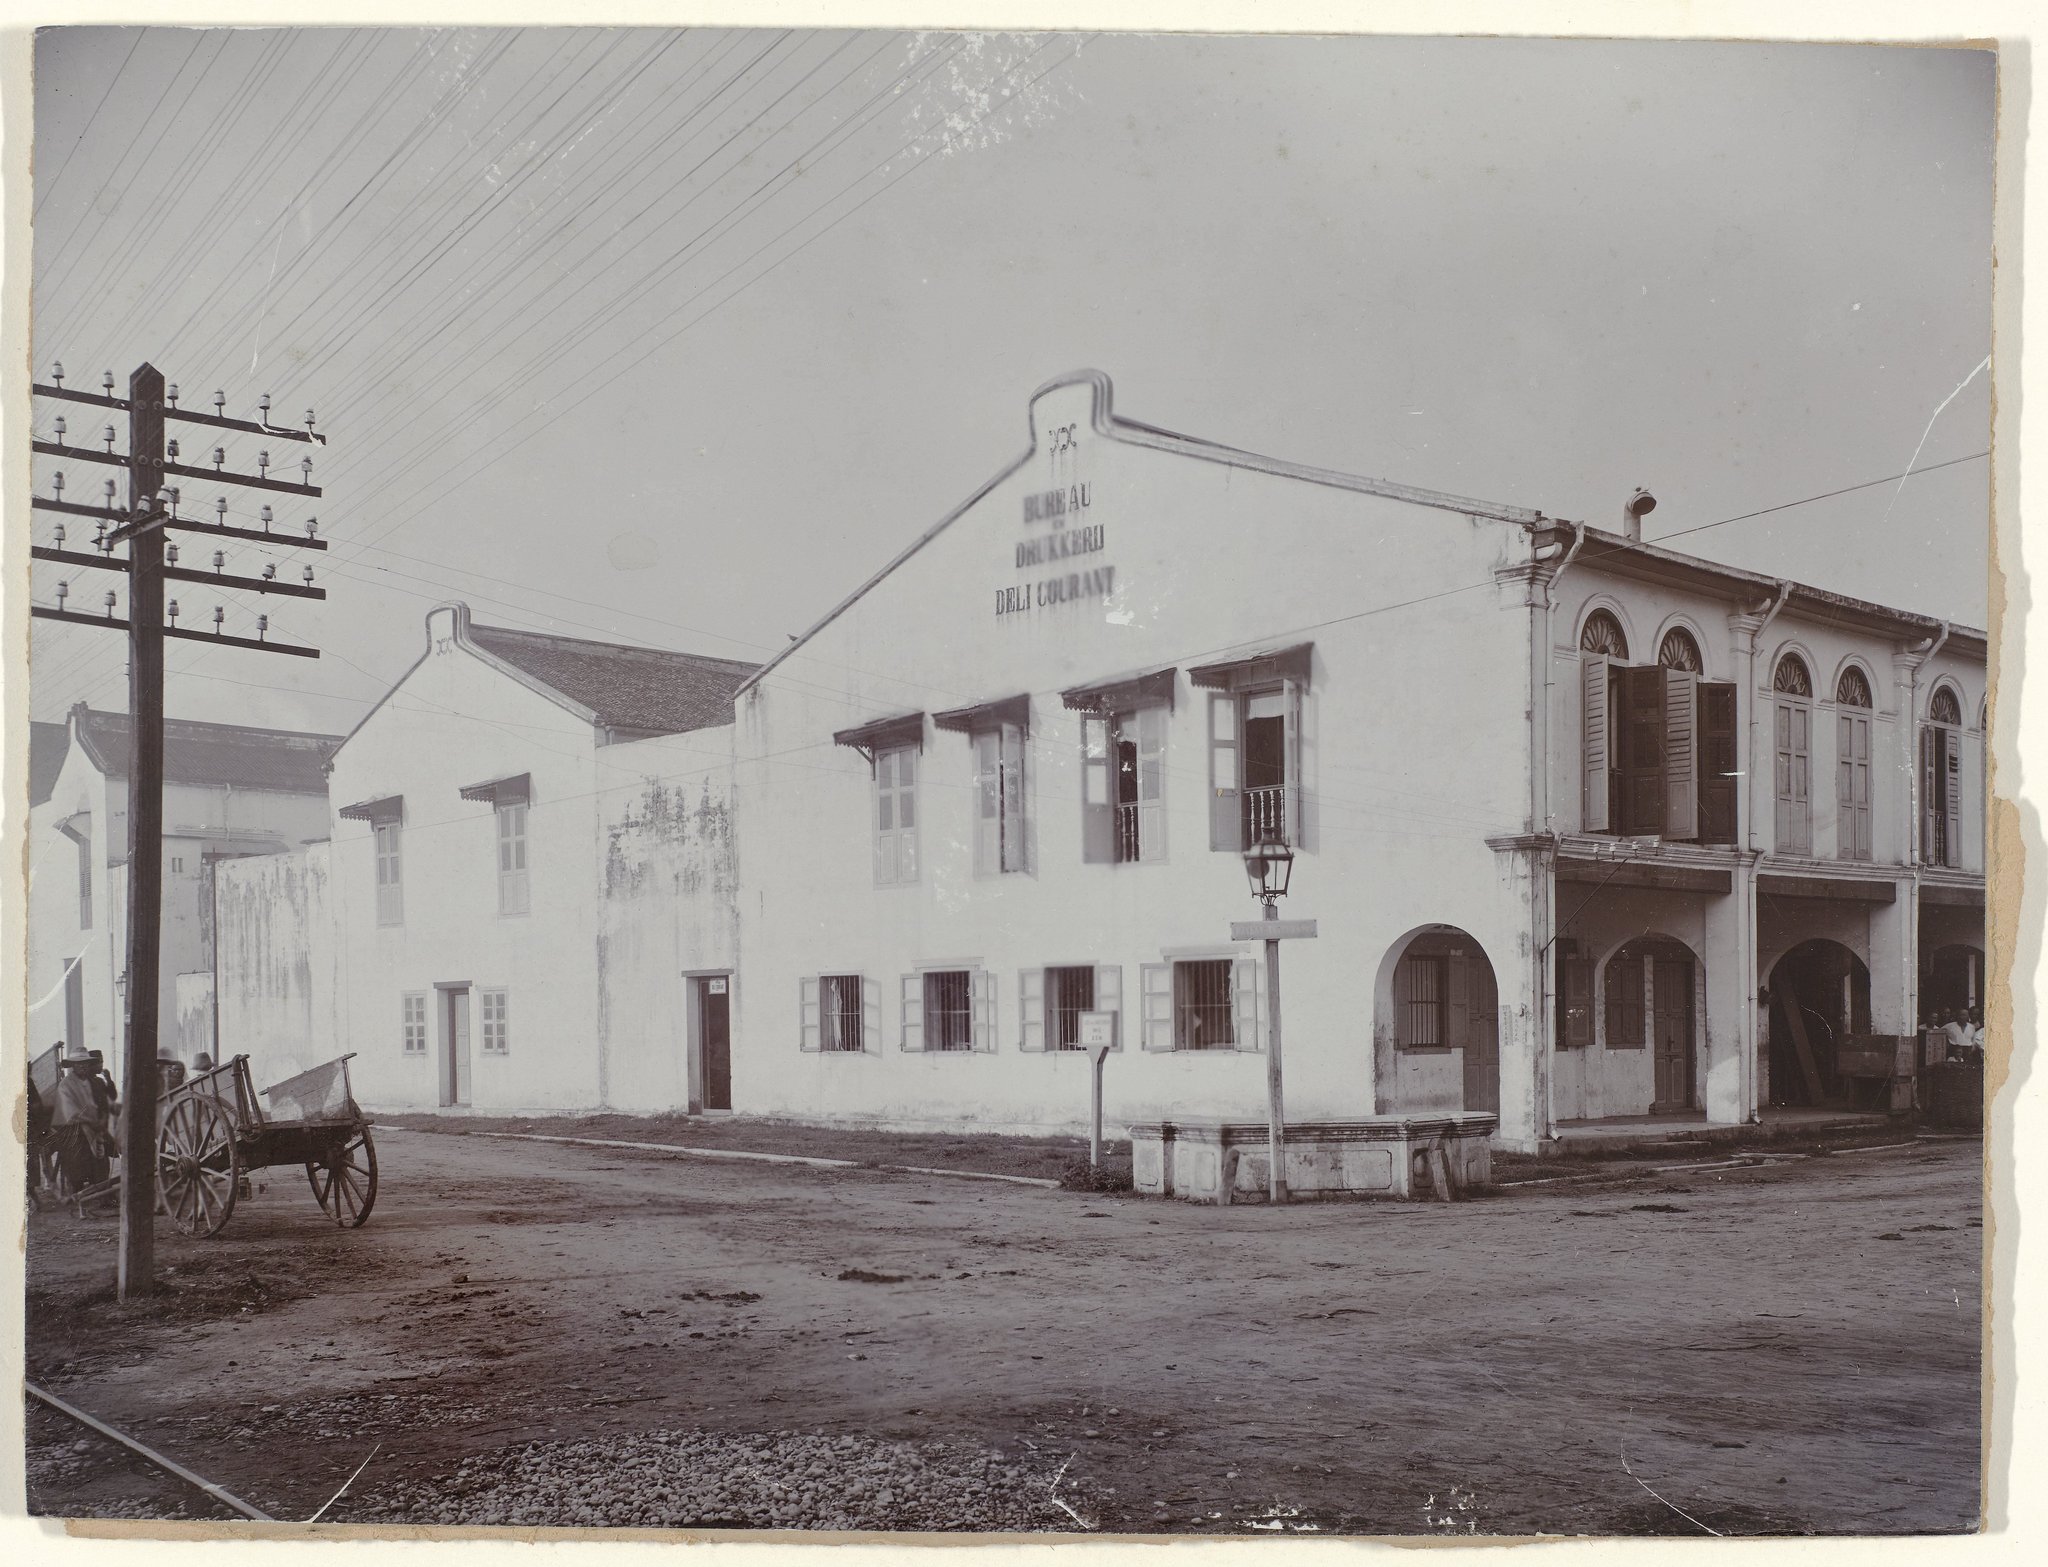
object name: photograph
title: Bureau en drukkerij van de Deli Courant te Medan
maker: Anonymous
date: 1890-1910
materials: cardboard, photographic support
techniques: albumen print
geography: medan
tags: dutch east indies, the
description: Straatgezicht met het gebouw van het bureau en drukkerij van de Deli Courant te Medan. Onderdeel van een groep van 49 losse zwart-wit foto's van verschillend formaat over de uitgeverij en drukkerij van de krant Deli Courant in Medan in de periode 1885-1947.